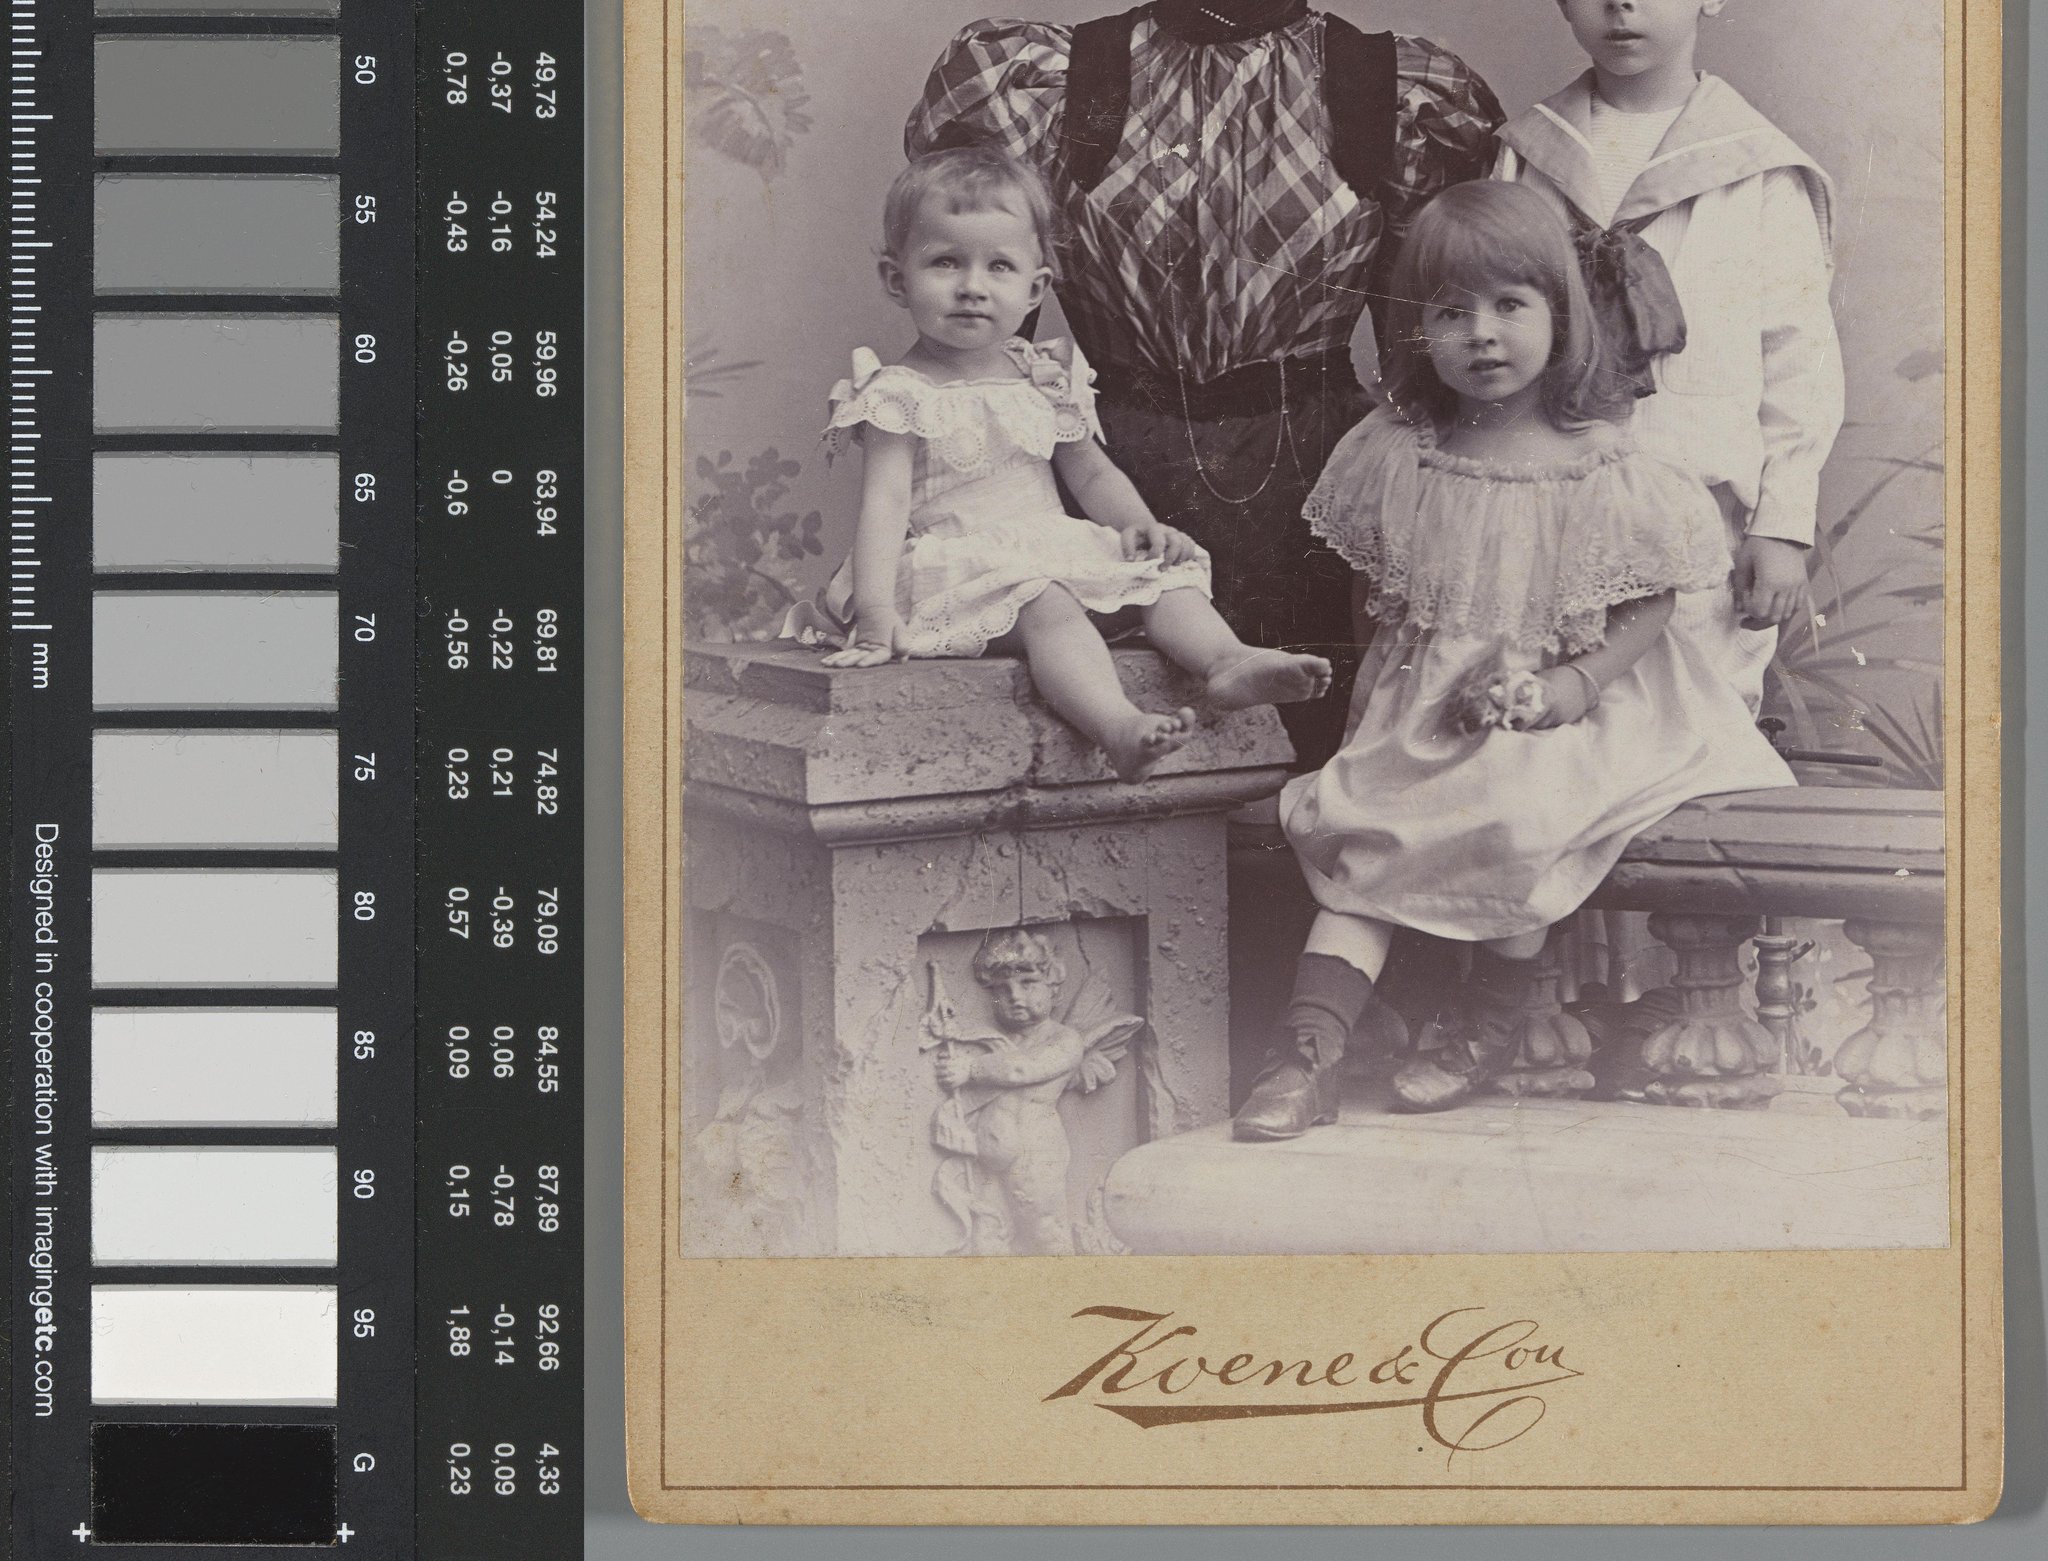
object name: cabinet photograph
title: Studioportret van Emilie van den Berg met drie kinderen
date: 1885-1910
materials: cardboard, photographic support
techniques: albumen print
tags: batavia, emilie albertine onnen-van den berg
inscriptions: name: ‘Koene & Co’, name: ‘BATAVIA / Koene & Co / AMSTERDAM / ALKMAAR’